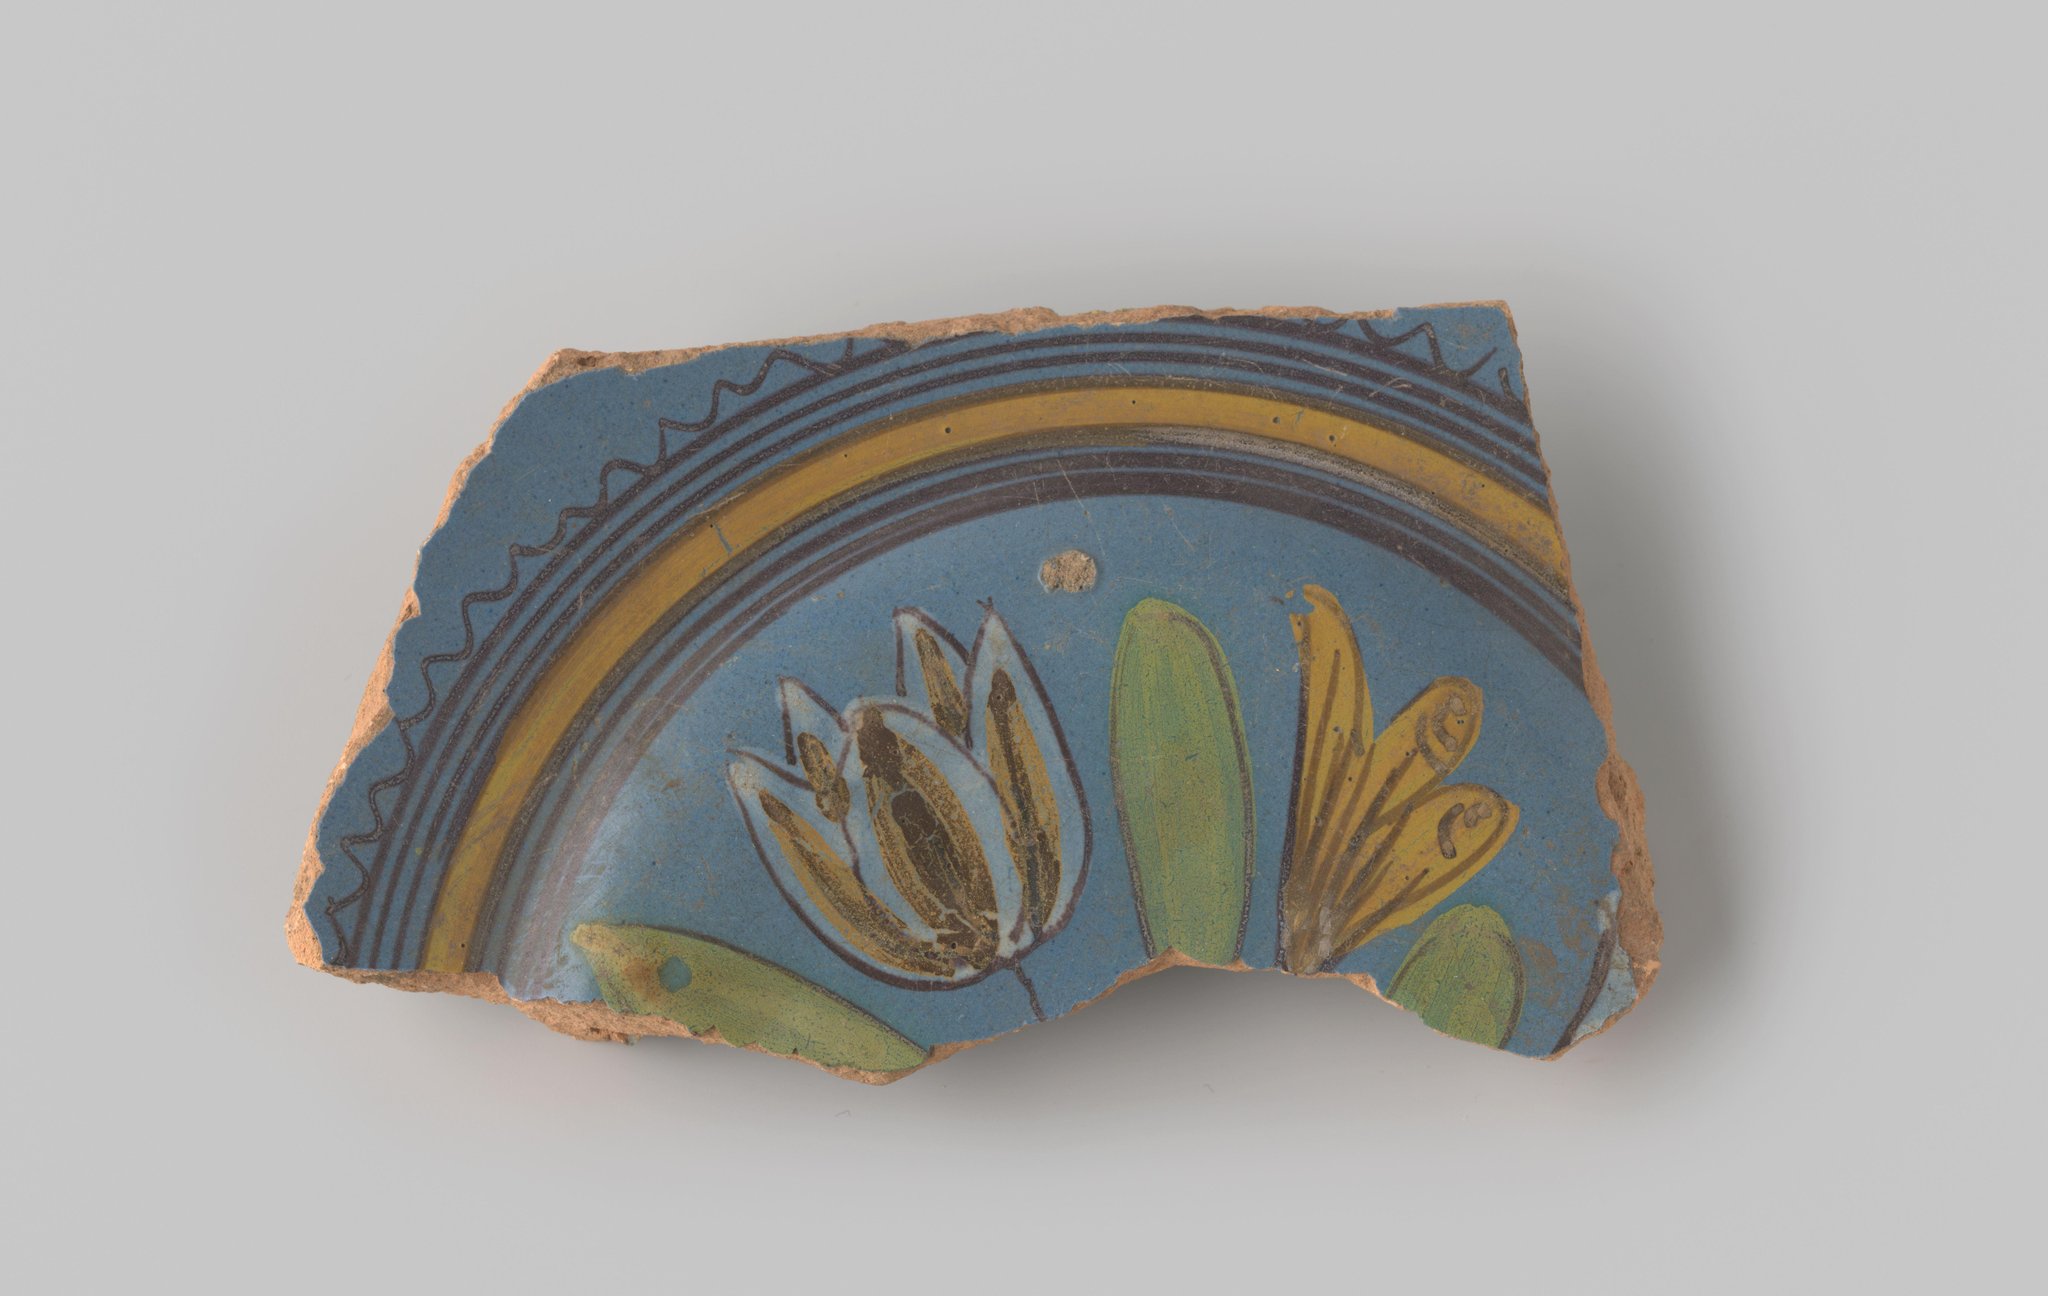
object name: sherd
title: Scherf van rossigbakkend aardewerk, aan de bovenzijde voorzien van blauw glazuur met decoratie van een tafereel met twee bloemen die in de aarde staan in bruin, wit, geel, oranje en groen, en enkele cirkels in bruin en geel eromheen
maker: Anonymous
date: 1600-1650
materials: earthenware, glaze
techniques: maiolica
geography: northern netherlands